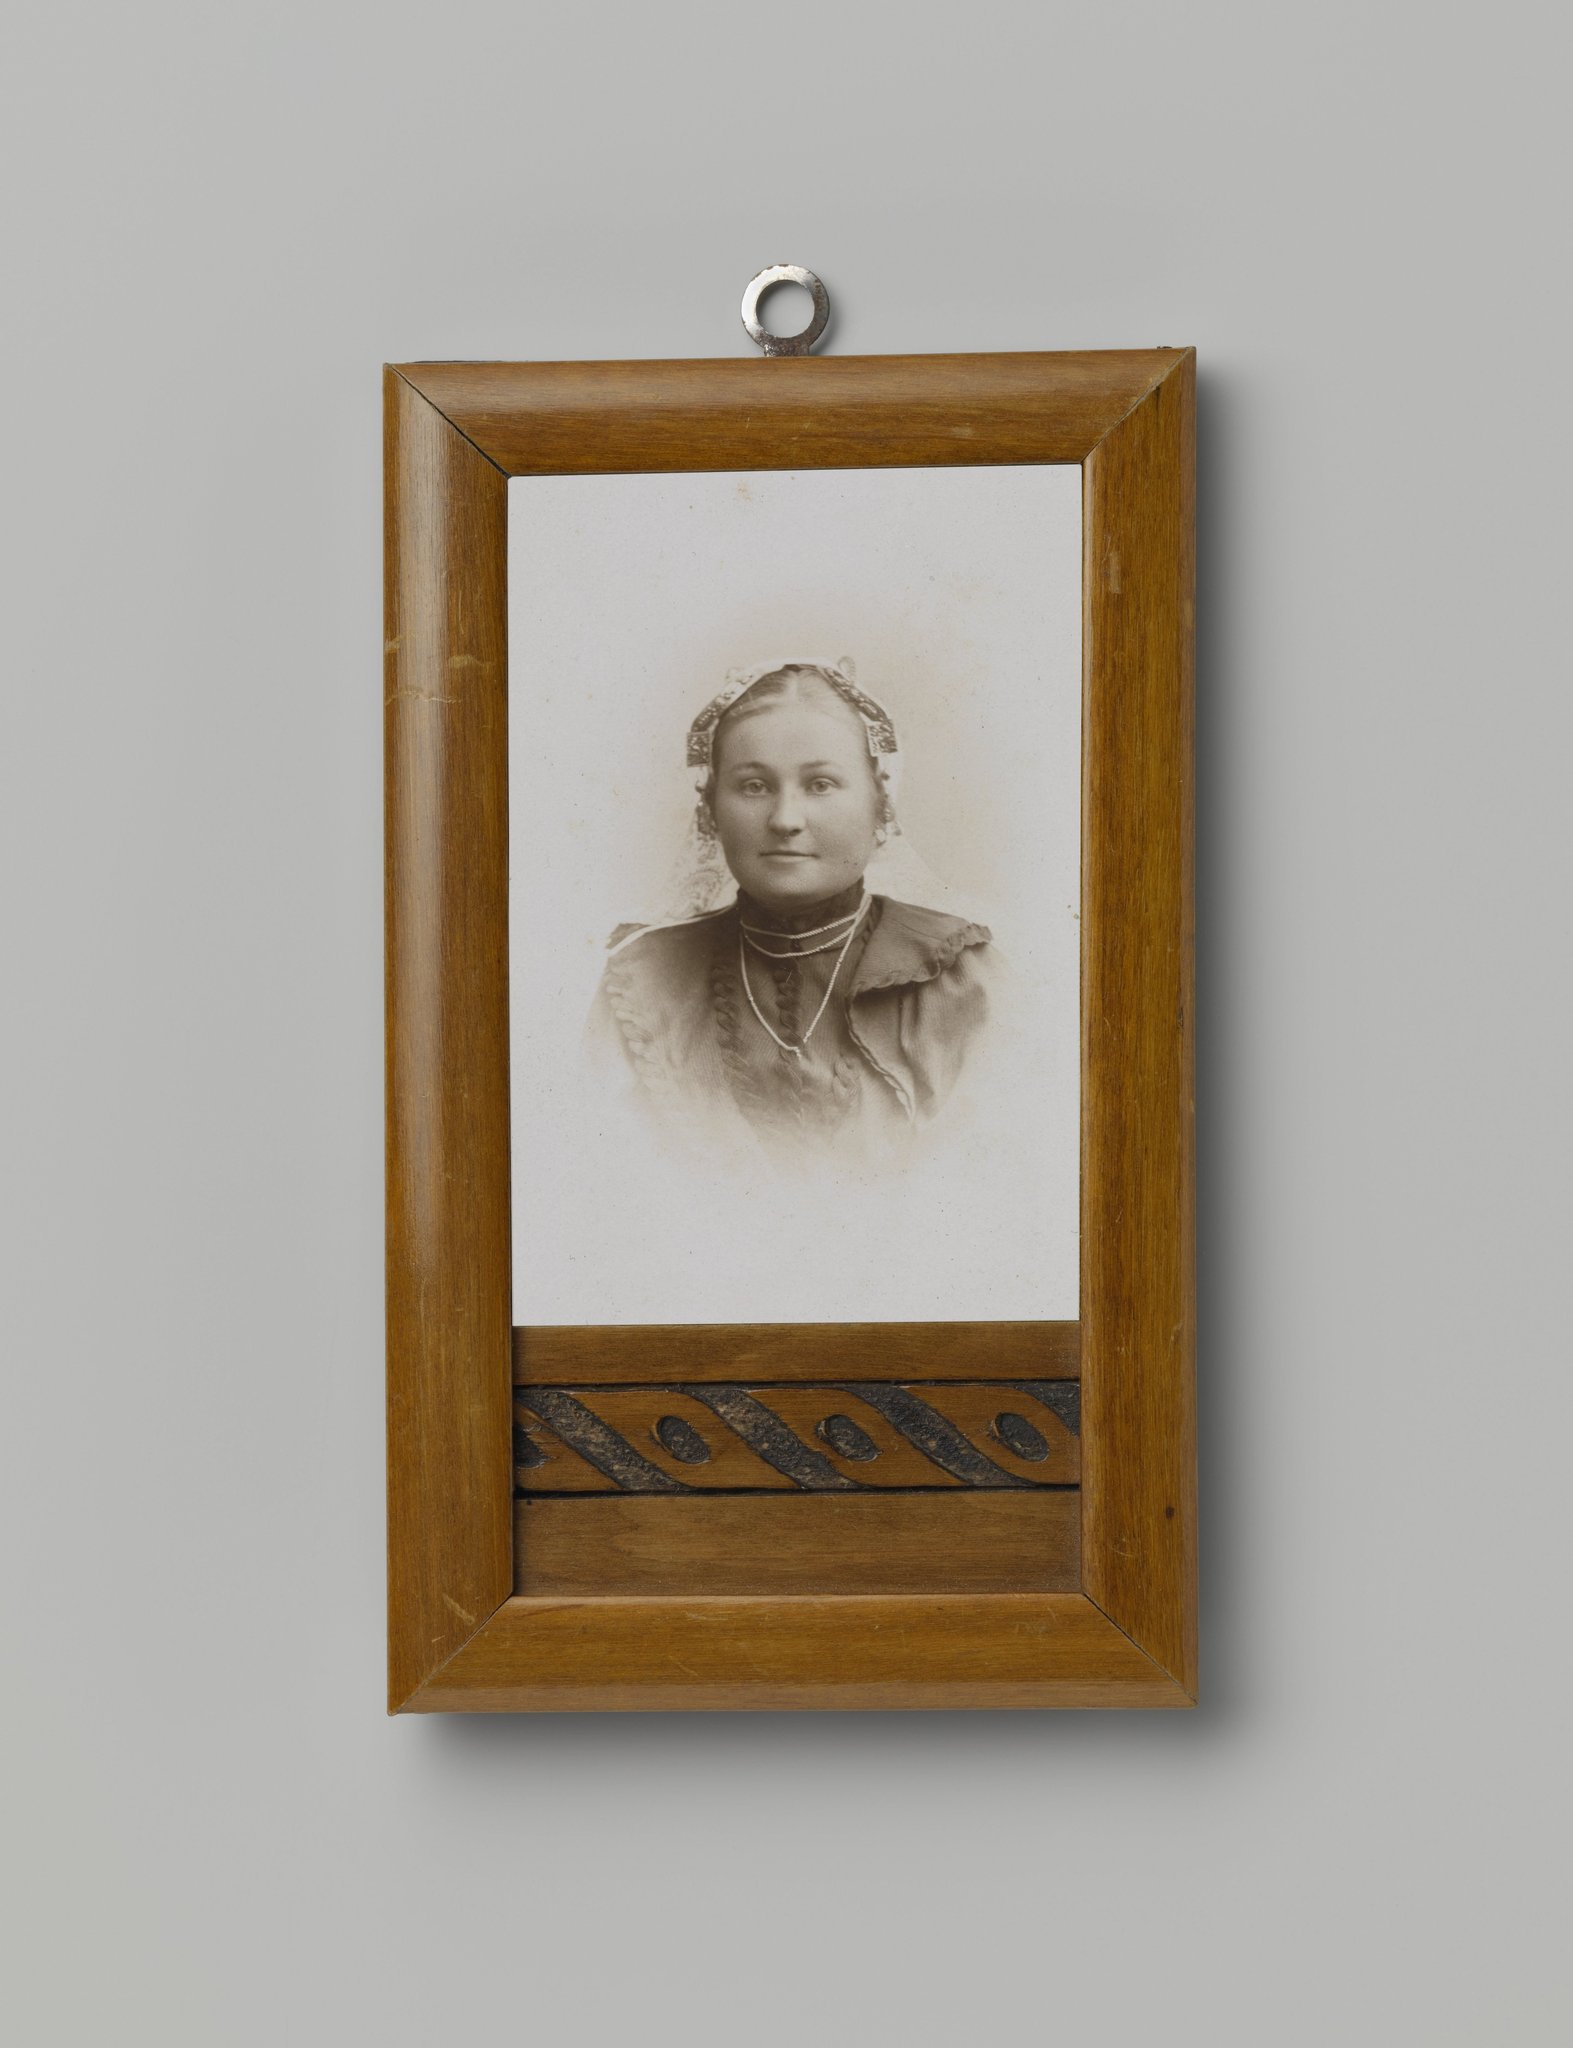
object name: frame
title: Photo Frames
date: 1888-1901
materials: paper, cardboard, wood, glass, metal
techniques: collodion silver print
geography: haarlem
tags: head-gear: cap, anonymous historical person portrayed - bb - woman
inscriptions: inscription: ‘C.F. & L.J. Cordes/ HAARLEM/ Groote Houtstraat 84,/ 's BOSCH a/d. Parade./ Op verschillende tentoonstellingen bekroond voor Vergrootingen/ in kooldruk en andere photographien./ Met de hoogste onderscheiding op de Tentoonstelling van/ Kunstnijverheid te 's HAGE./ De clichés blijven ter nabestelling bewaard./ Specialiteit in Kooldruk Vergrootingen.’